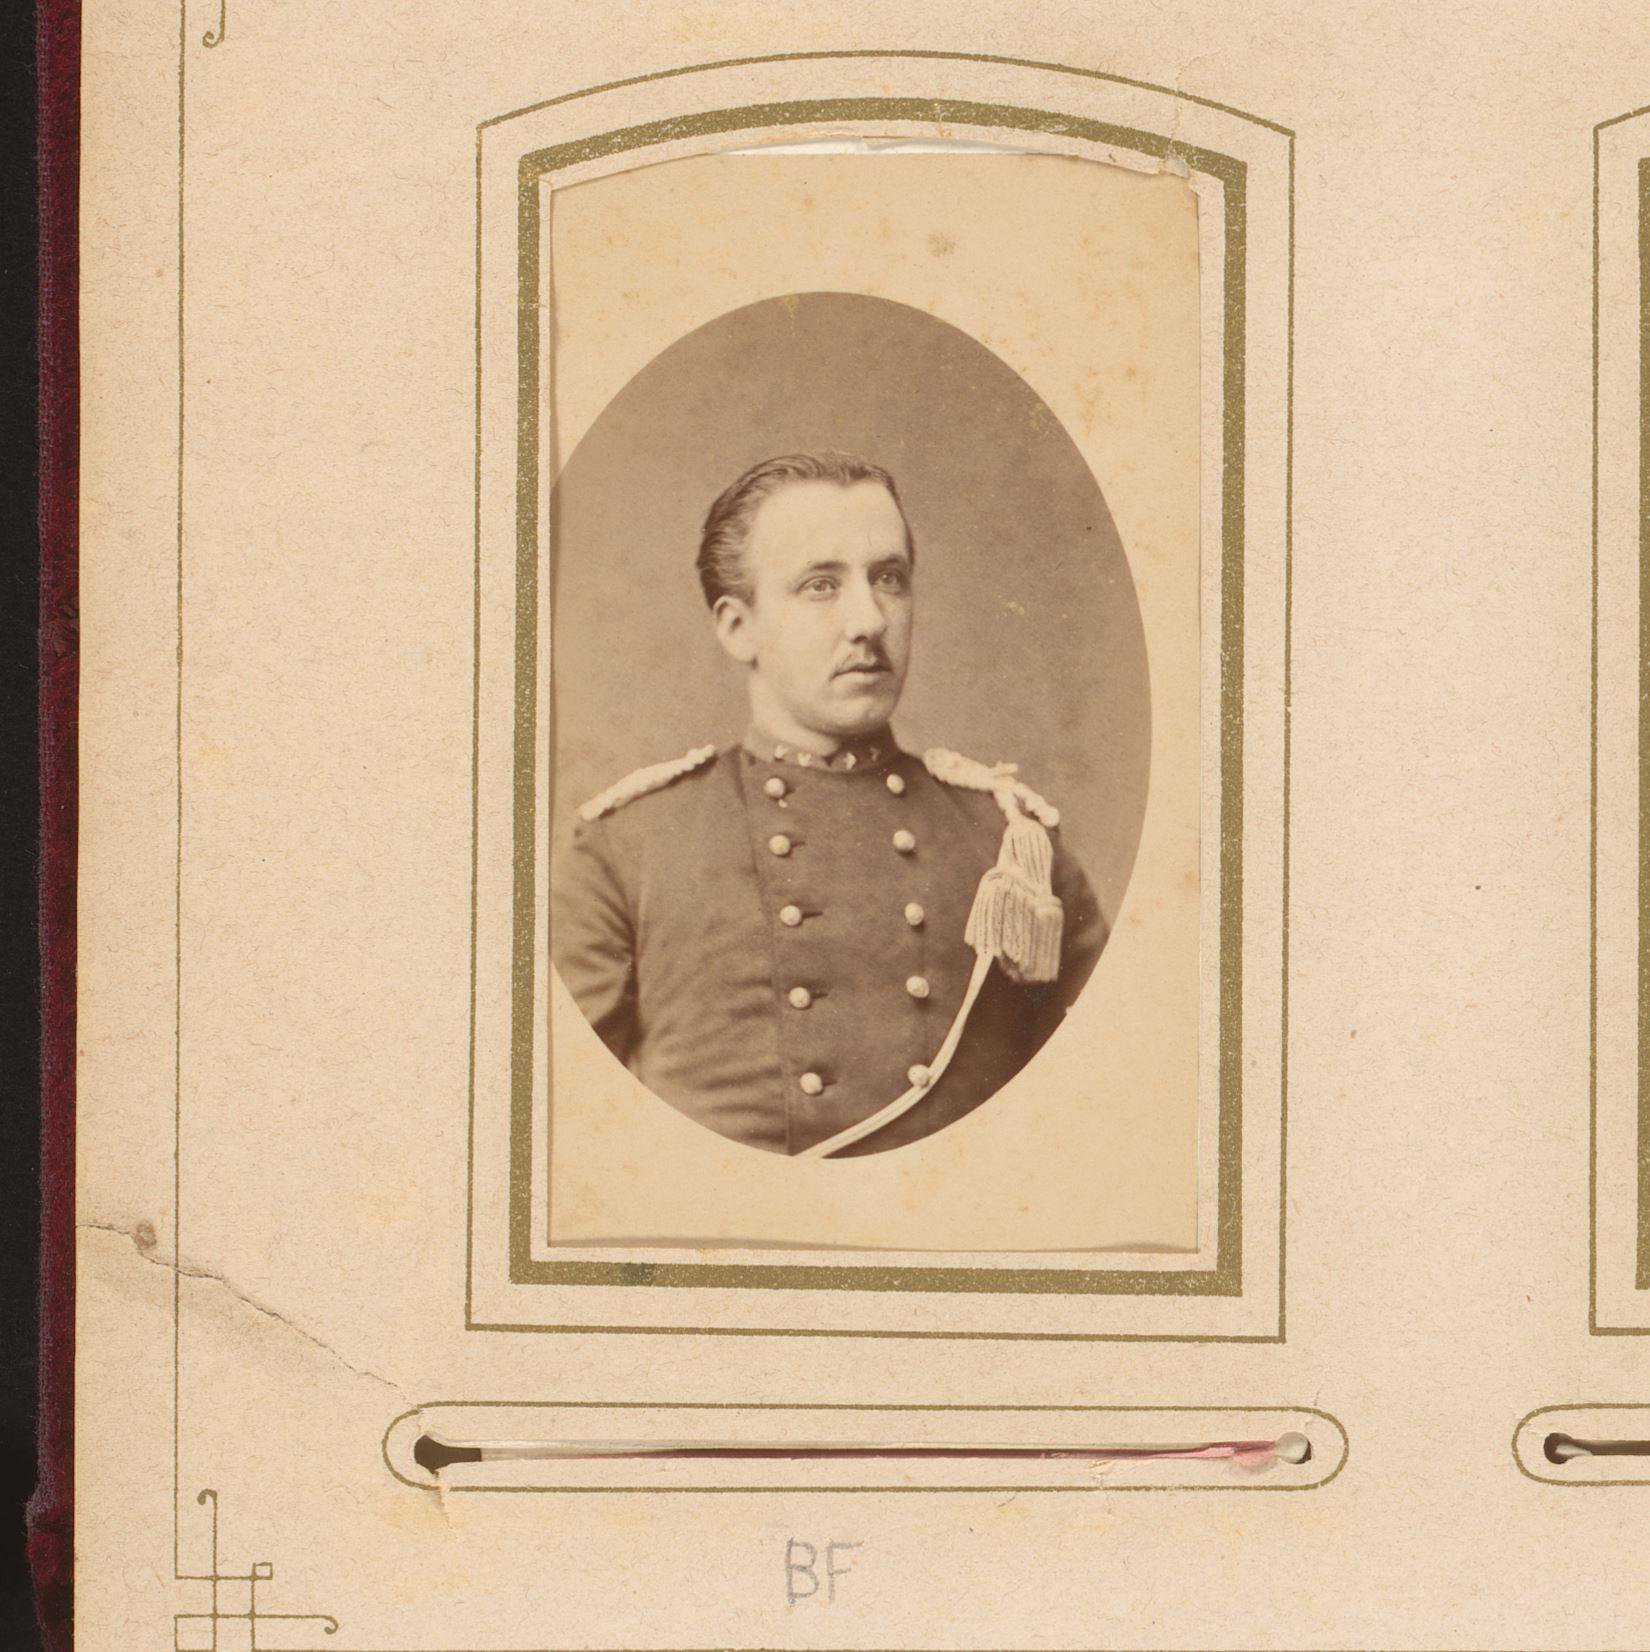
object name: photograph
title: Portret van een man in militair uniform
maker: bernardus bruining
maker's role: fotograaf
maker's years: 1834-1900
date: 1875-1877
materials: cardboard, photographic support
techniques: albumen print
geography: leiden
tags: historical persons, (military) uniforms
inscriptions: inscription: ‘B. BRUINING/ PHOTOGRAPHE/ van/ Z.K.H. PRINS FREDERIK/ DER NEDERLANDEN/ te/ LEIDEN/ De plaat blijft tot nabestelling bewaard’